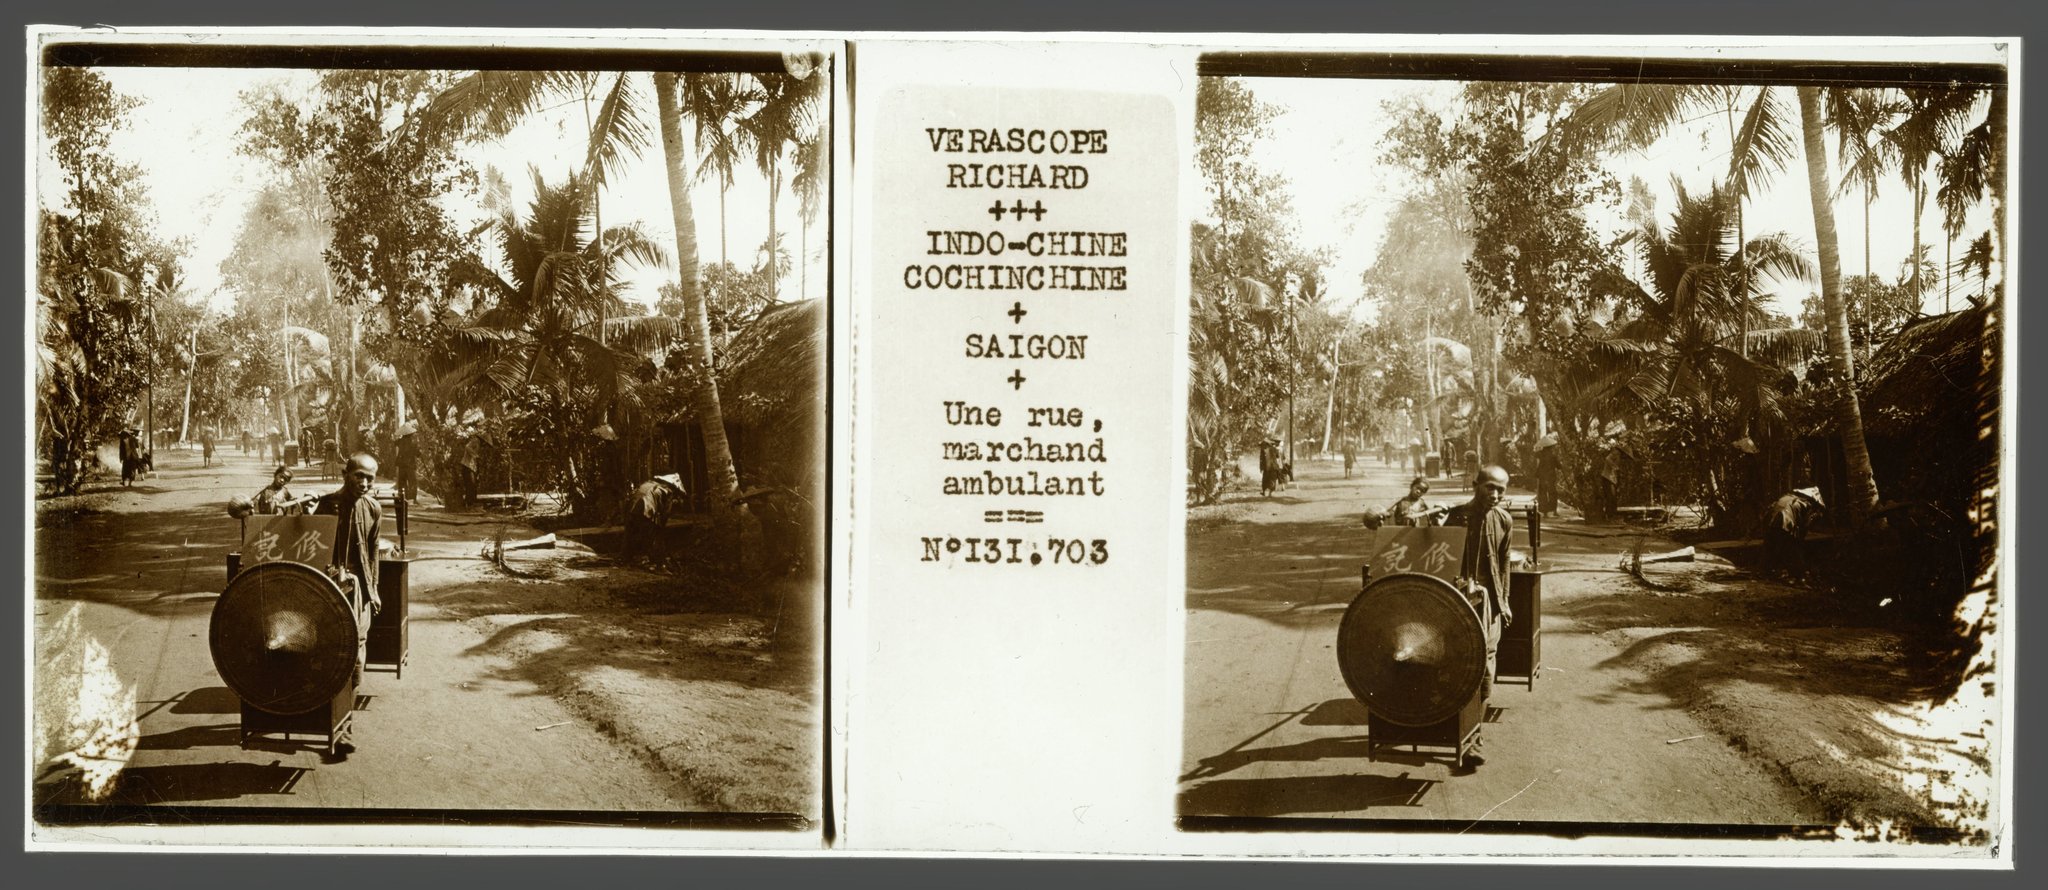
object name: stereoscopic photograph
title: Handelaar op straat in Frans-Indochina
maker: Anonymous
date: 1893-1920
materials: glass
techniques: gelatin silver transparency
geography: paris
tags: street-trader, street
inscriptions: number: ‘No 131.703’